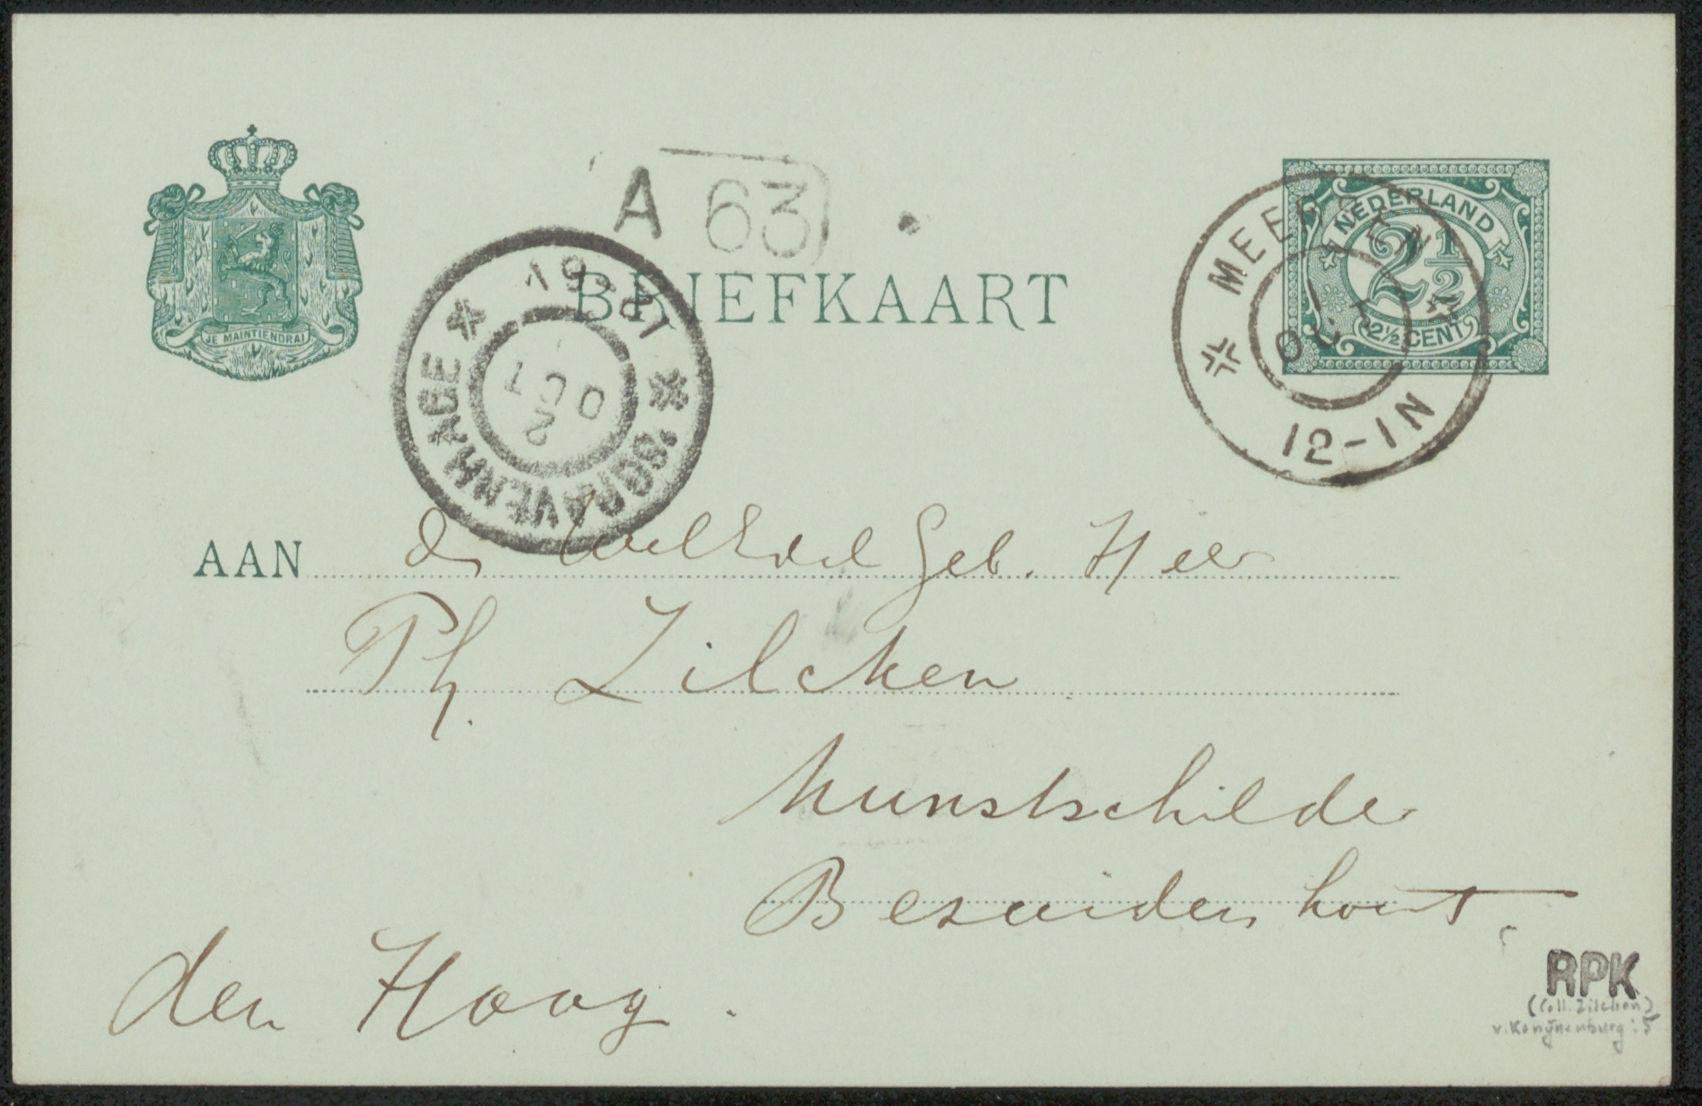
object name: postcard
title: Briefkaart aan Philip Zilcken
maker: willem van konijnenburg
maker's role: draughtsman, painter, print maker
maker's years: 1868-1943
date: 1900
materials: cardboard, ink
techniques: pen, writing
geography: meerssen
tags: leiden, philip zilcken, drawing, photography, cinematography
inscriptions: collector's mark: ‘RPK’